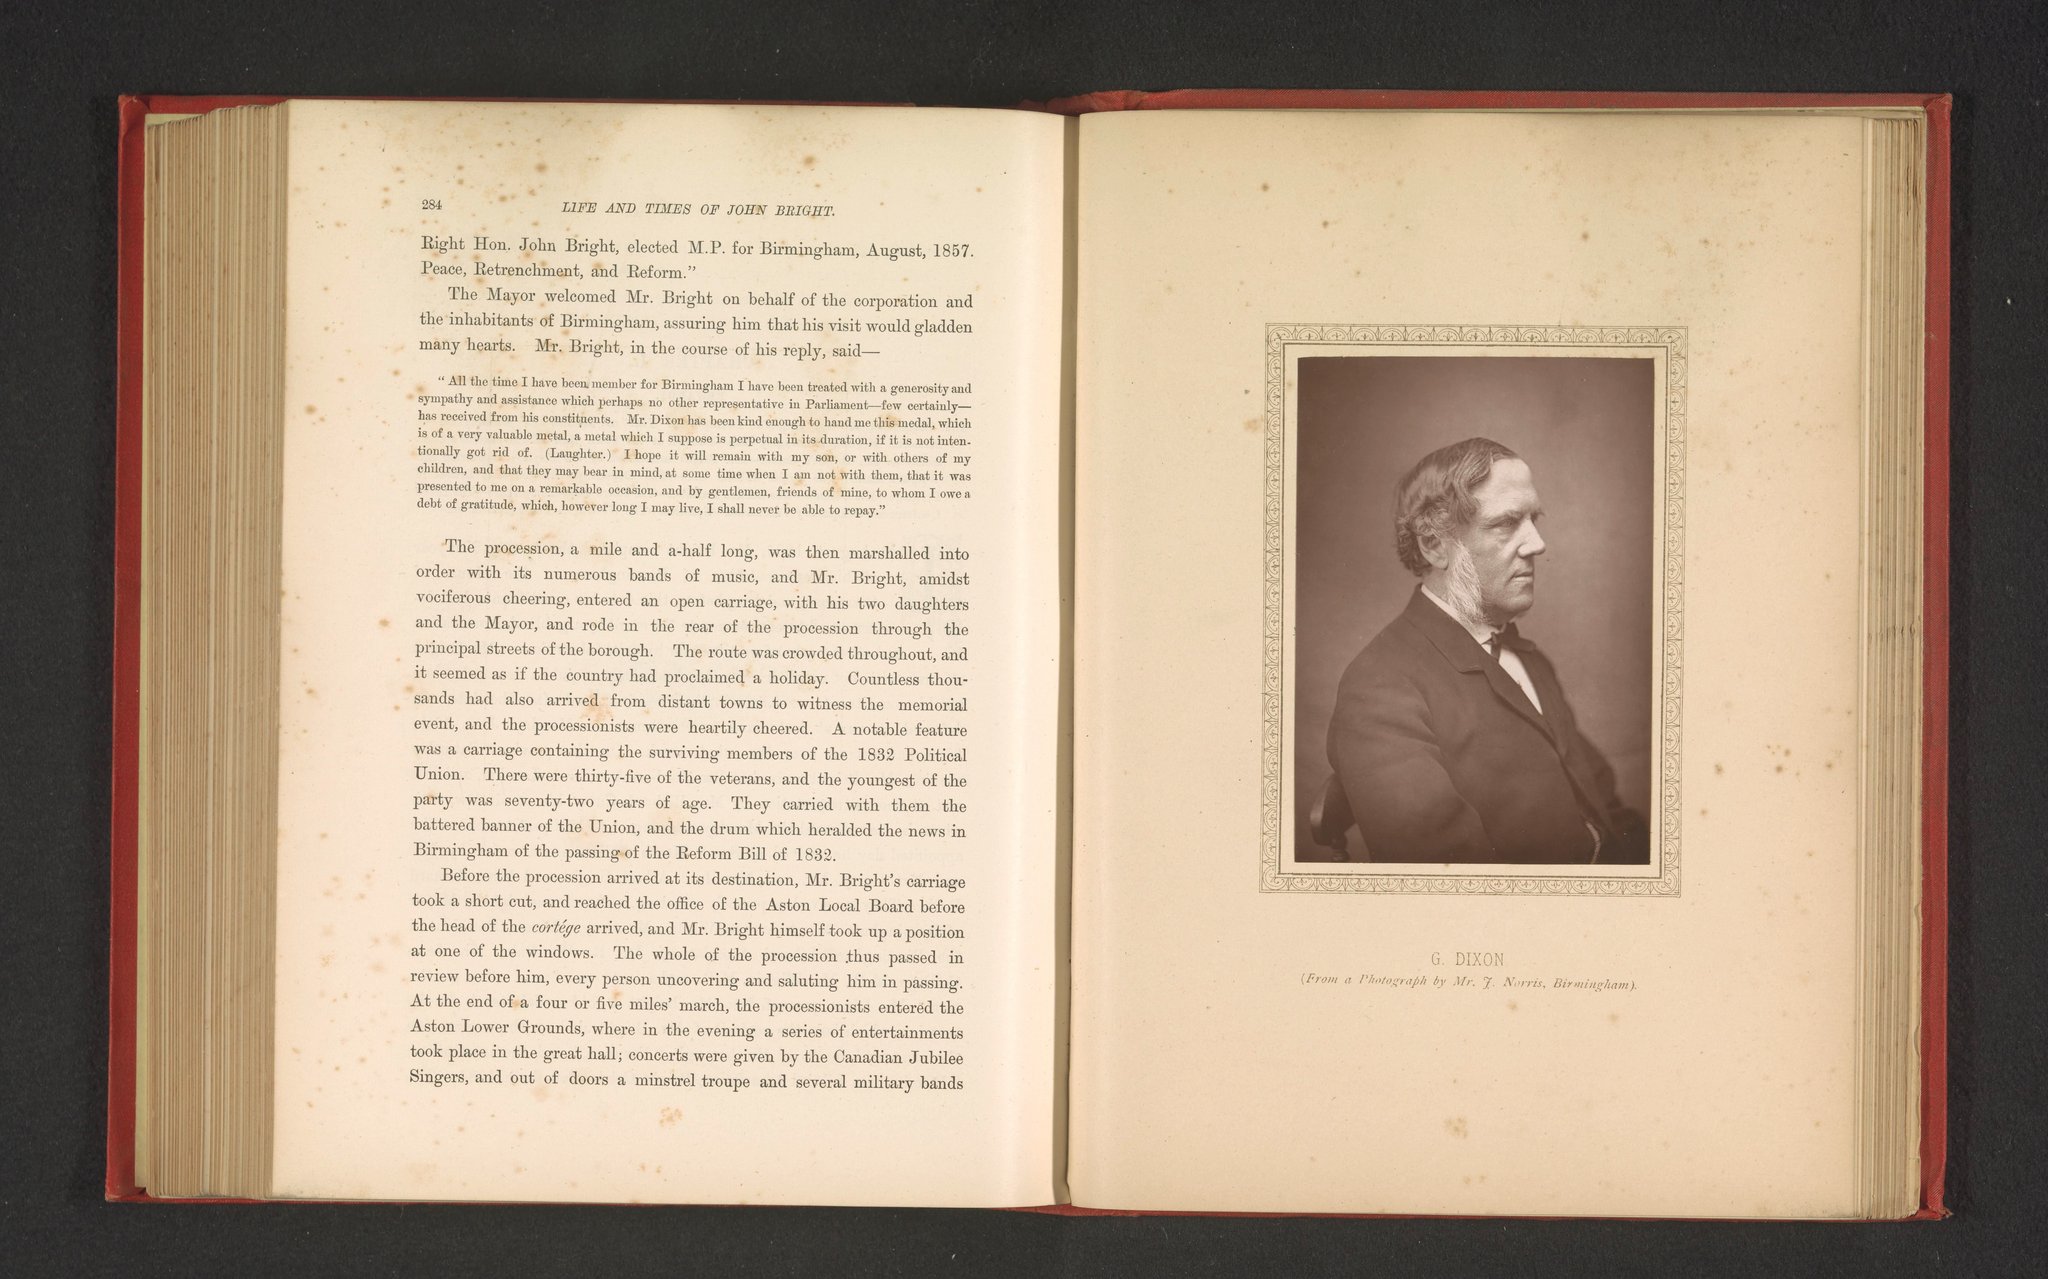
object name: photomechanical print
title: Portret van George Dixon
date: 1874-1884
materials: paper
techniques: woodburytype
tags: politician, politician, e.g. party leader